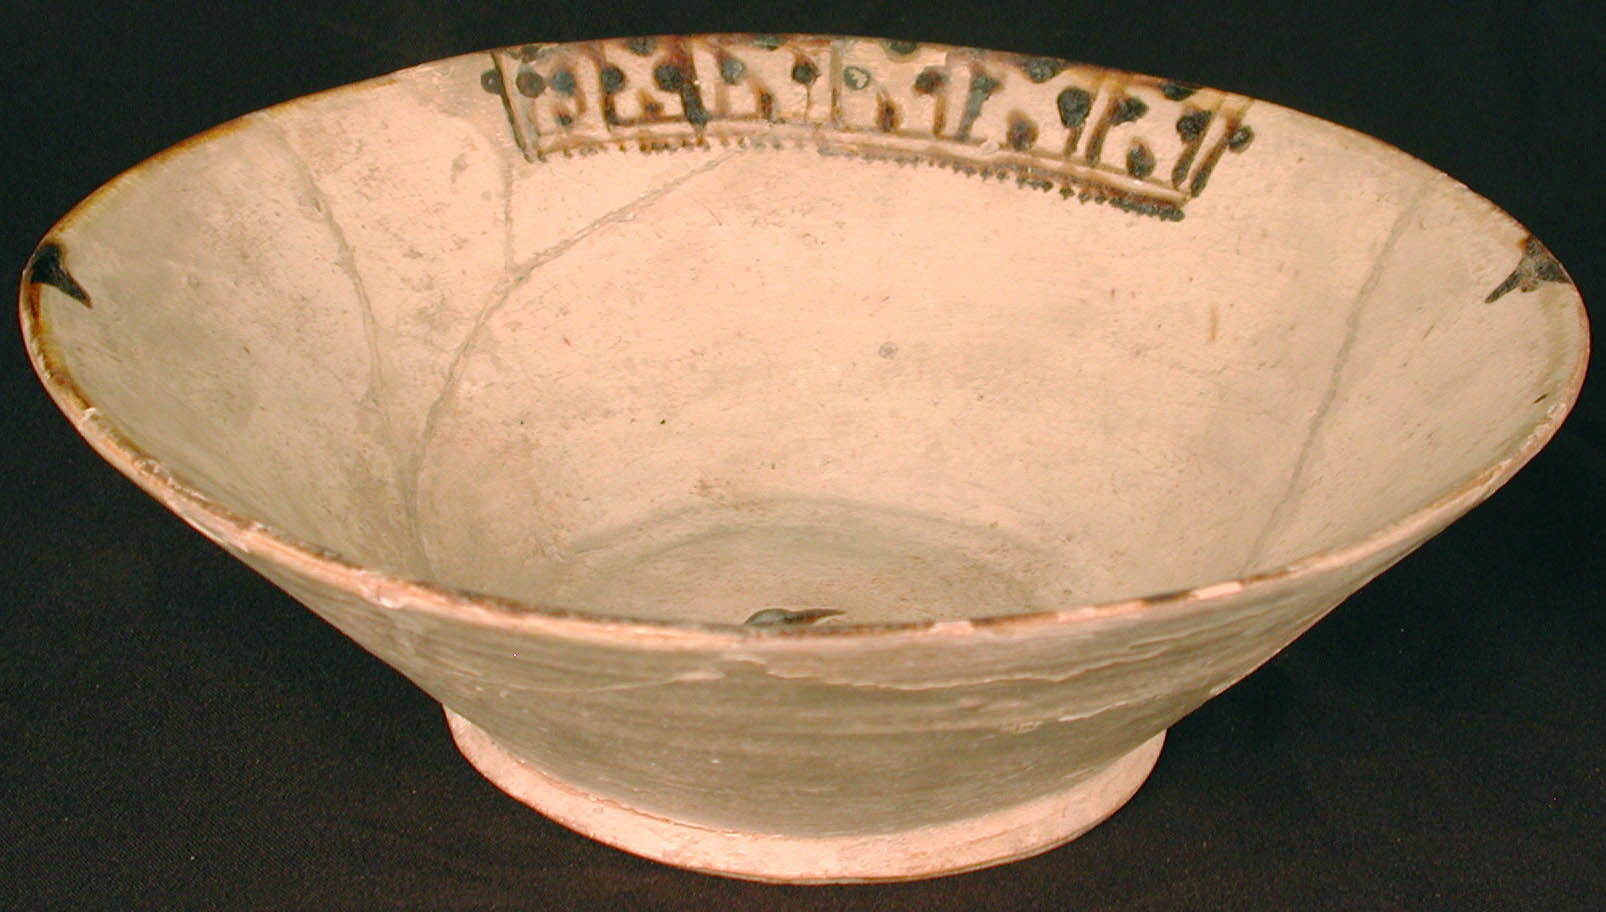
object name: bowl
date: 801-1000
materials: earthenware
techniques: glazing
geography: iran